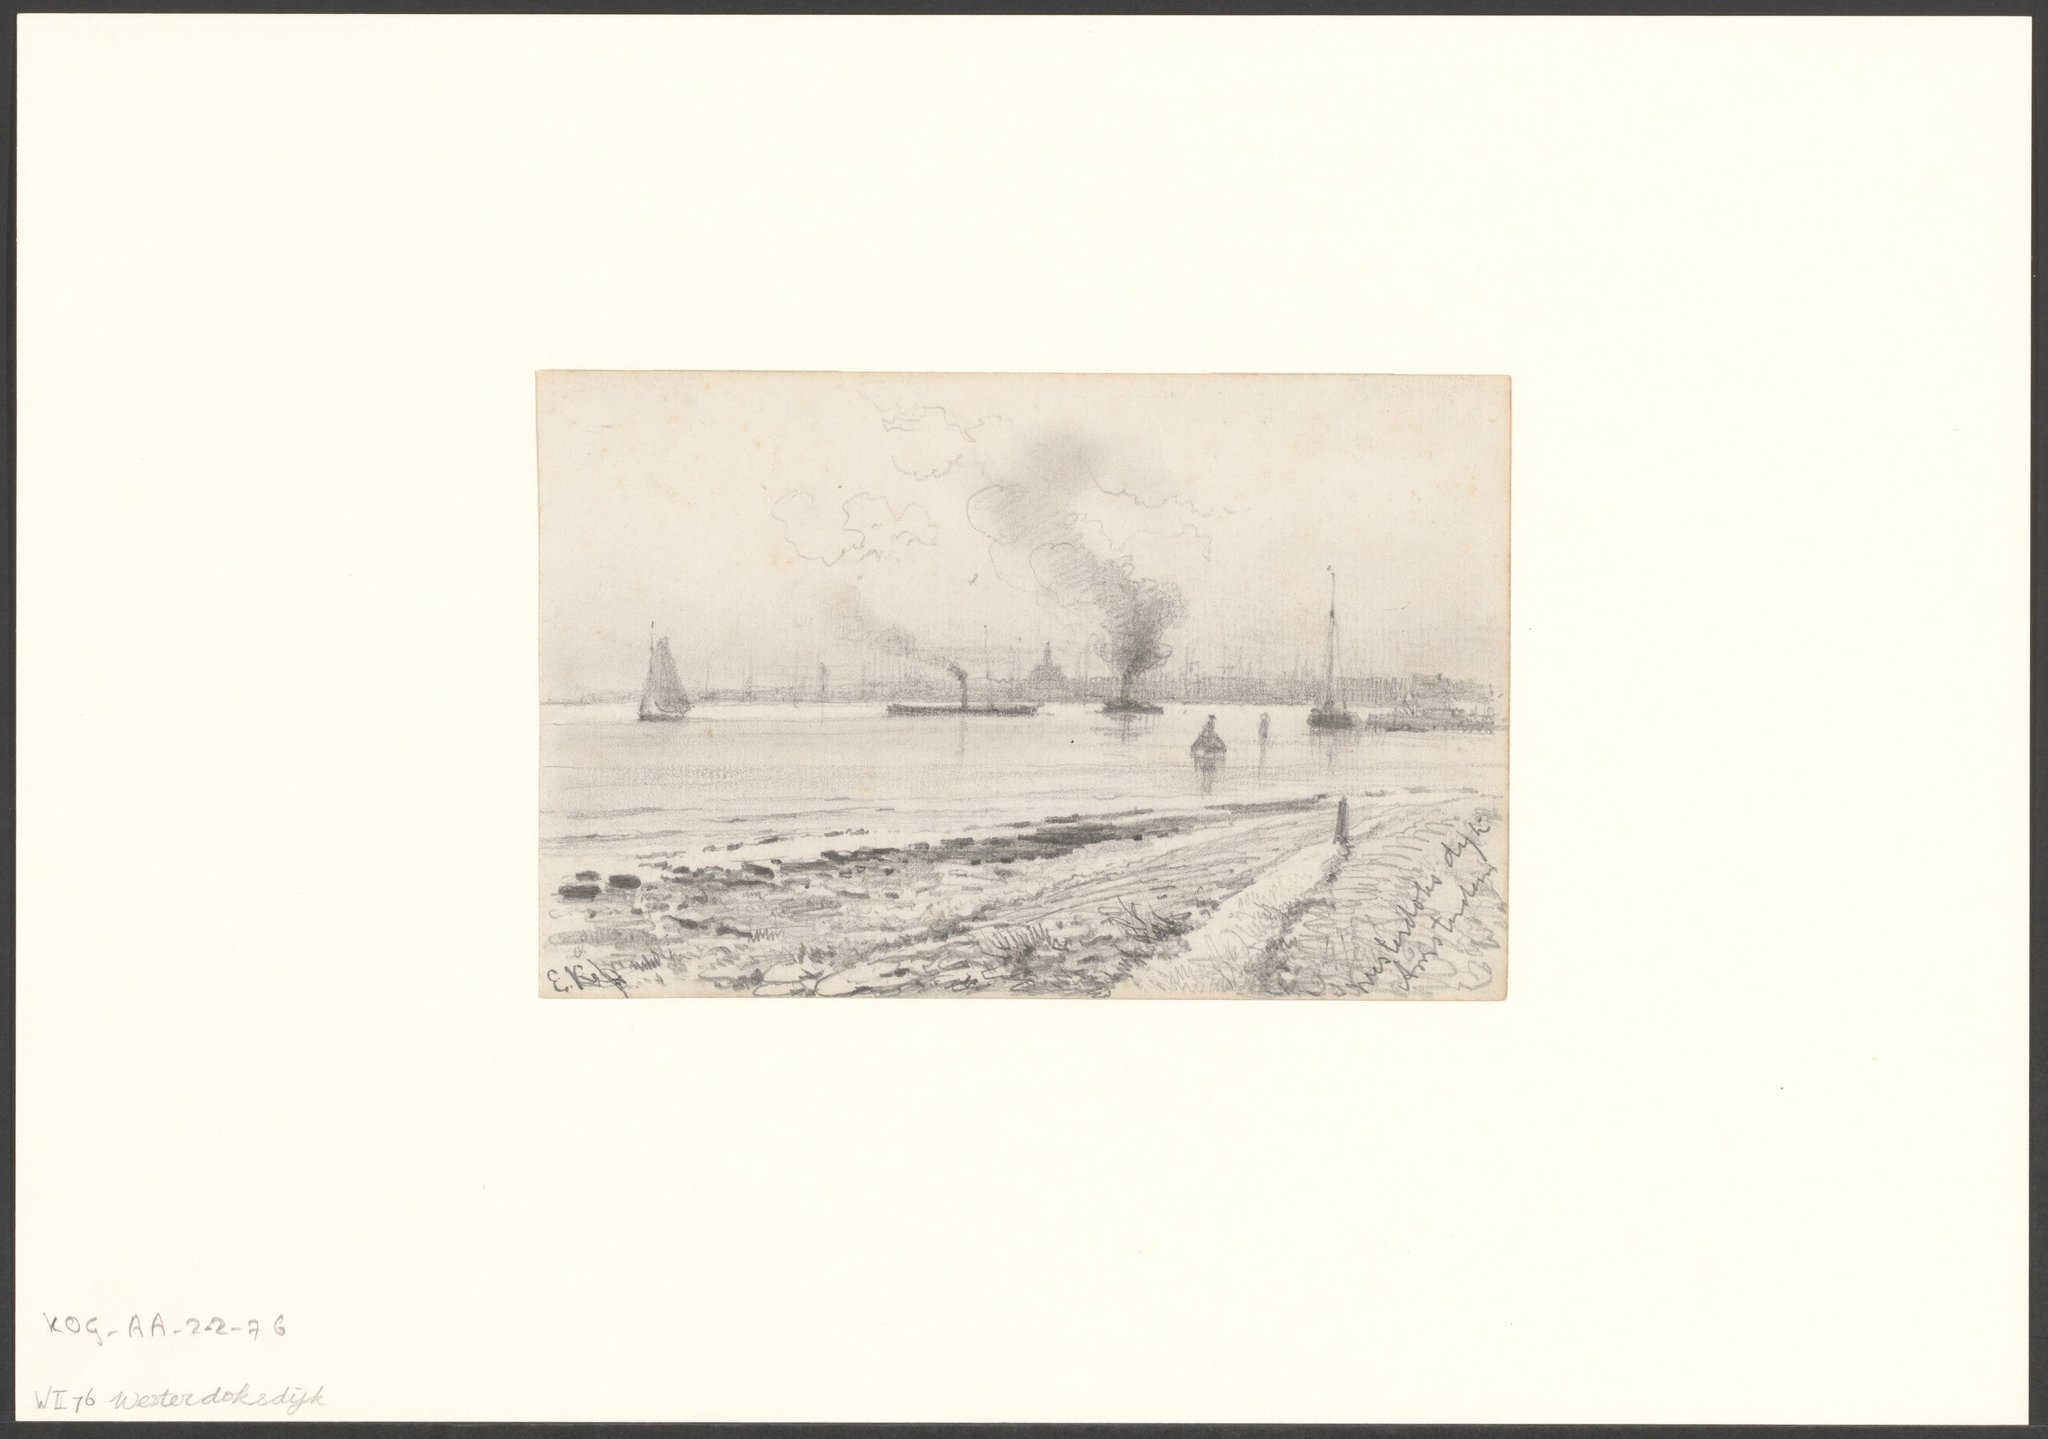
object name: drawing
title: Gezicht op de Westerdoksdijk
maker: everhardus koster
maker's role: draughtsman, painter, print maker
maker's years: 1817-1892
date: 1827-1892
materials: paper, pencil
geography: amsterdam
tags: sailing-ship, sailing-boat, city-view in general; 'veduta', river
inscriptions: inscription: ‘Westerdoks dijk / Amsterdam’, signature: ‘E.K.ft’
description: Tekening binnen de Atlas Van Eck ingedeeld op wijknummer 2.